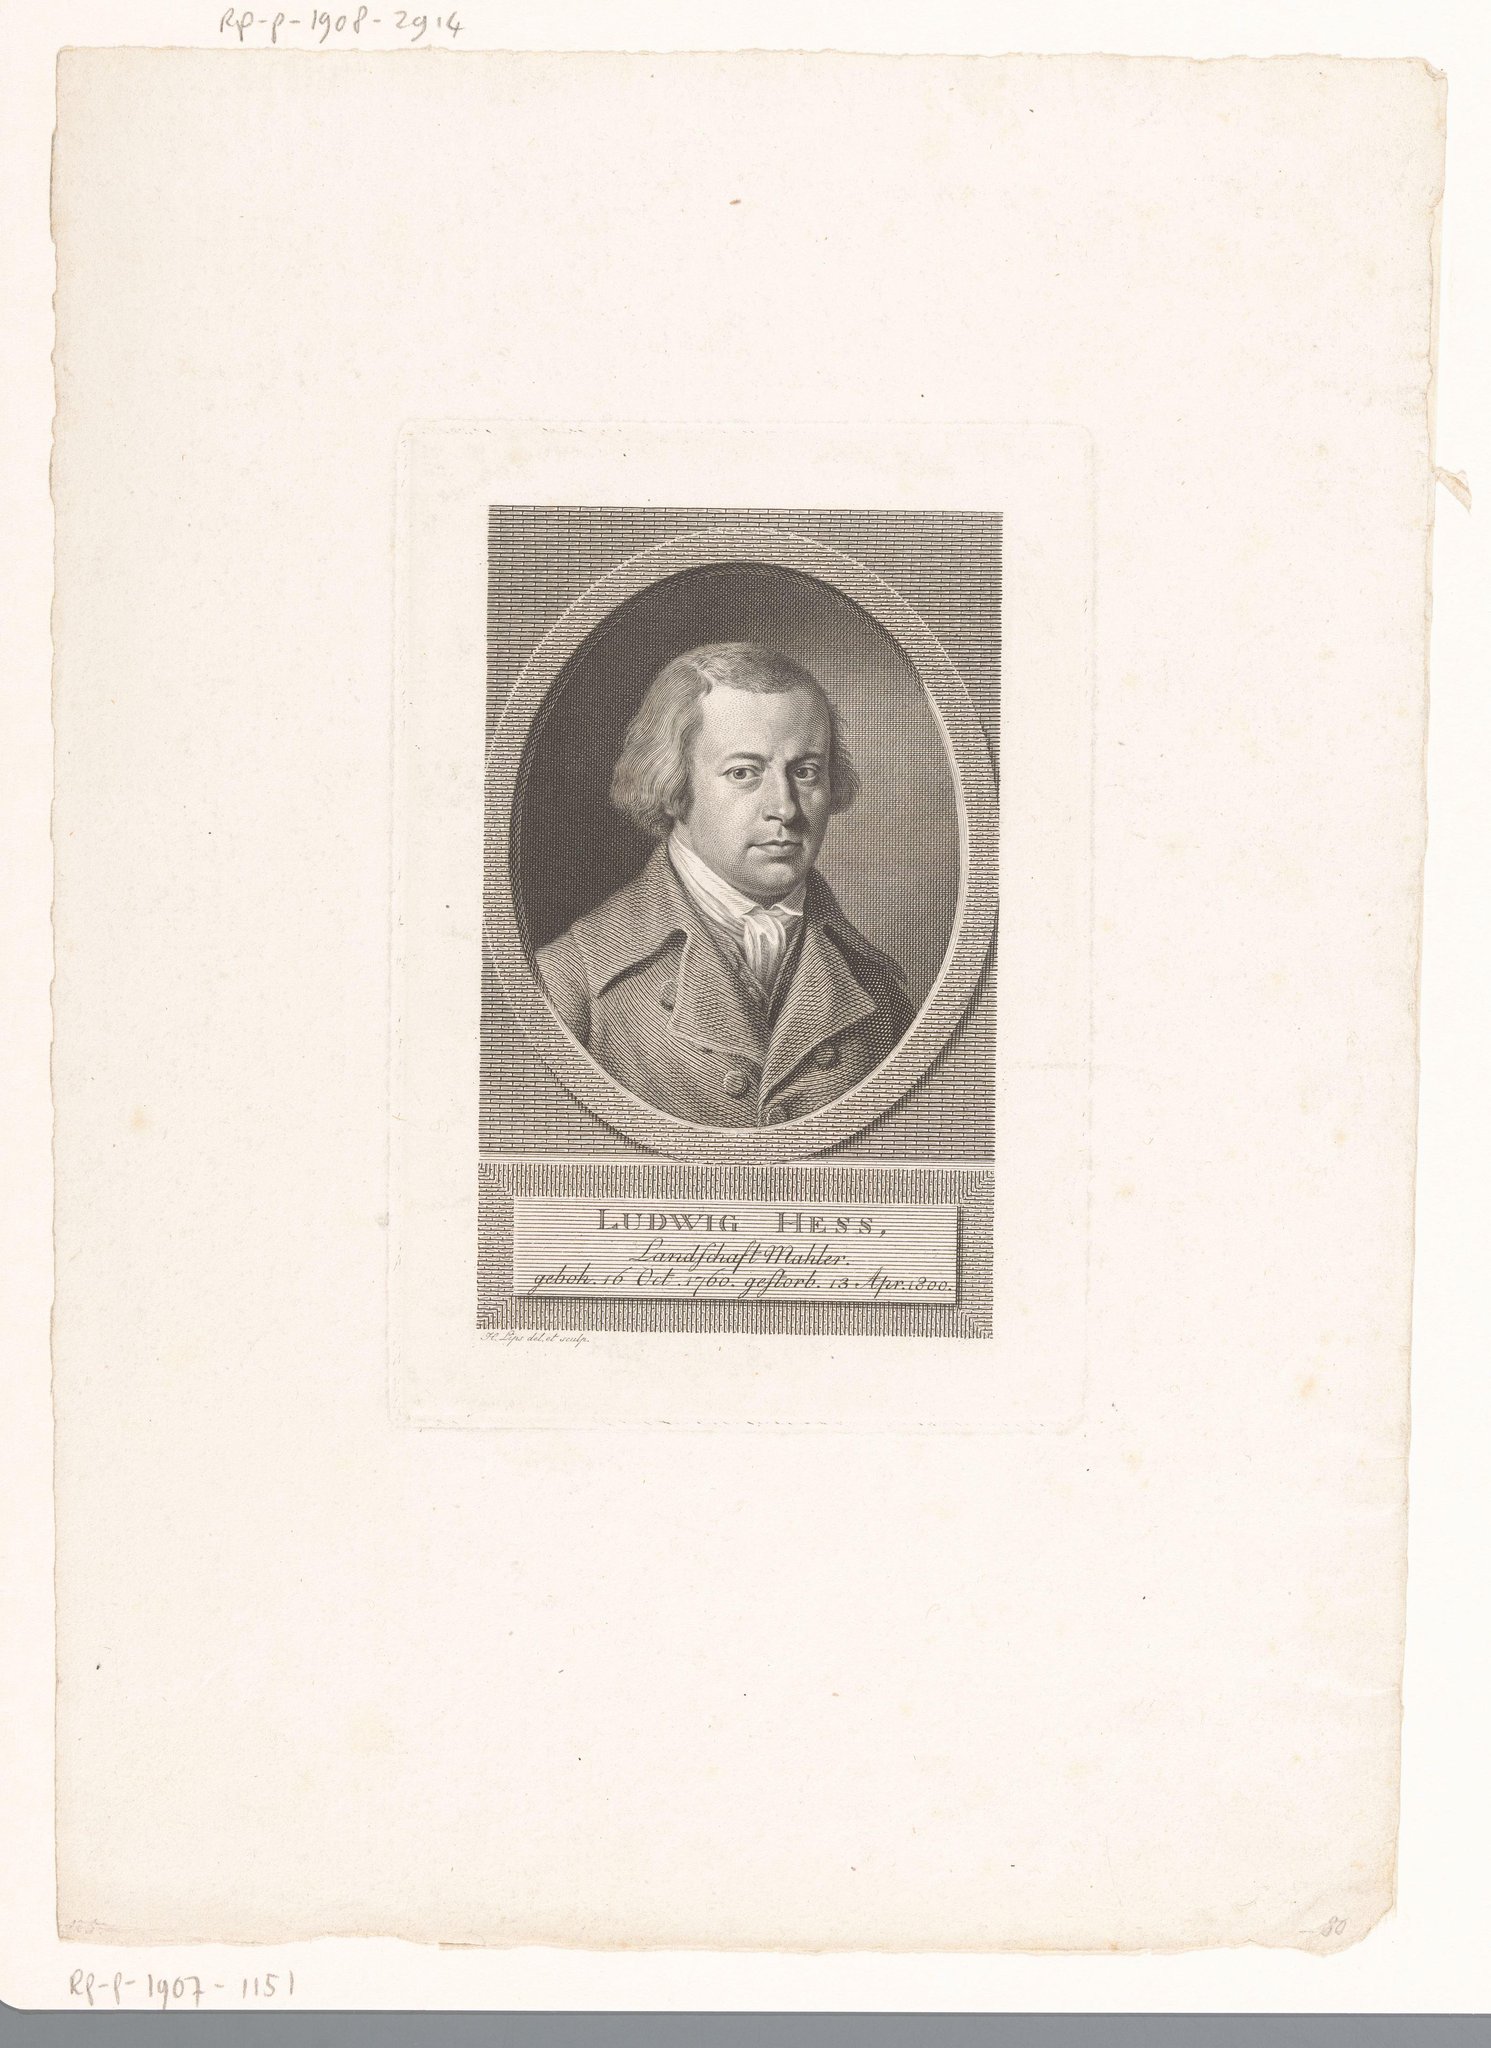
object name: print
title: Portret van Ludwig Hess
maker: johann heinrich lips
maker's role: draughtsman, painter, print maker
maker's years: 1758-1817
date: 1800-1817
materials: paper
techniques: engraving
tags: painter, ludwig hess, historical persons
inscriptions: collector's mark: Lugt 2228